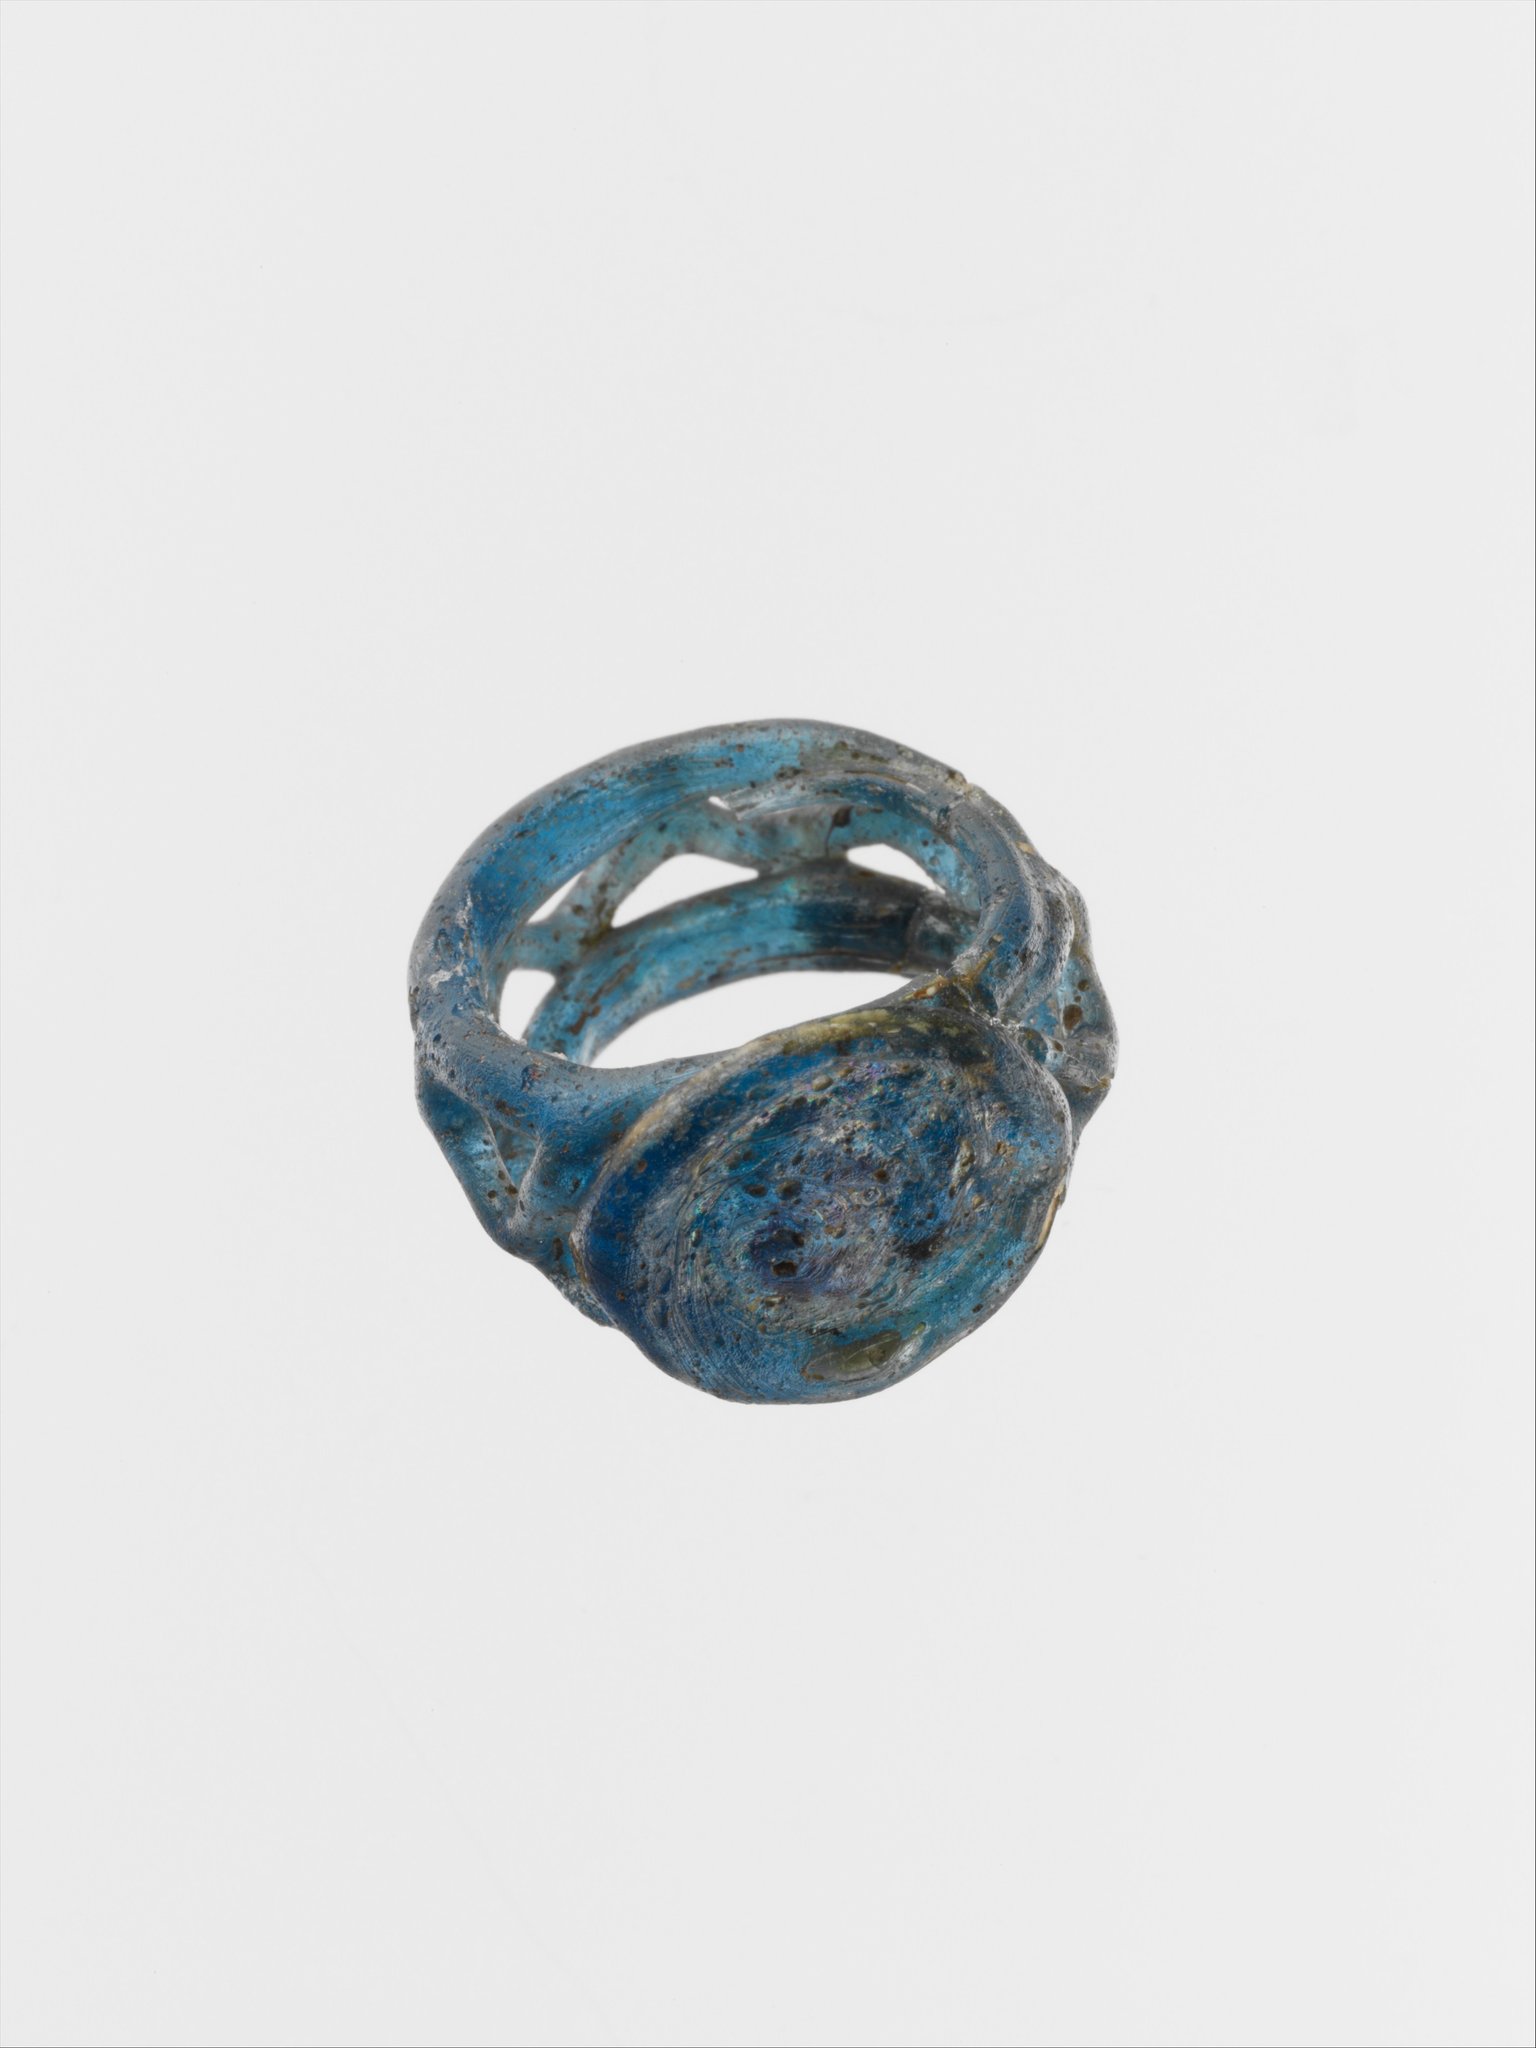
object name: ring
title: Glass openwork finger ring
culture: roman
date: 301-400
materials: glass